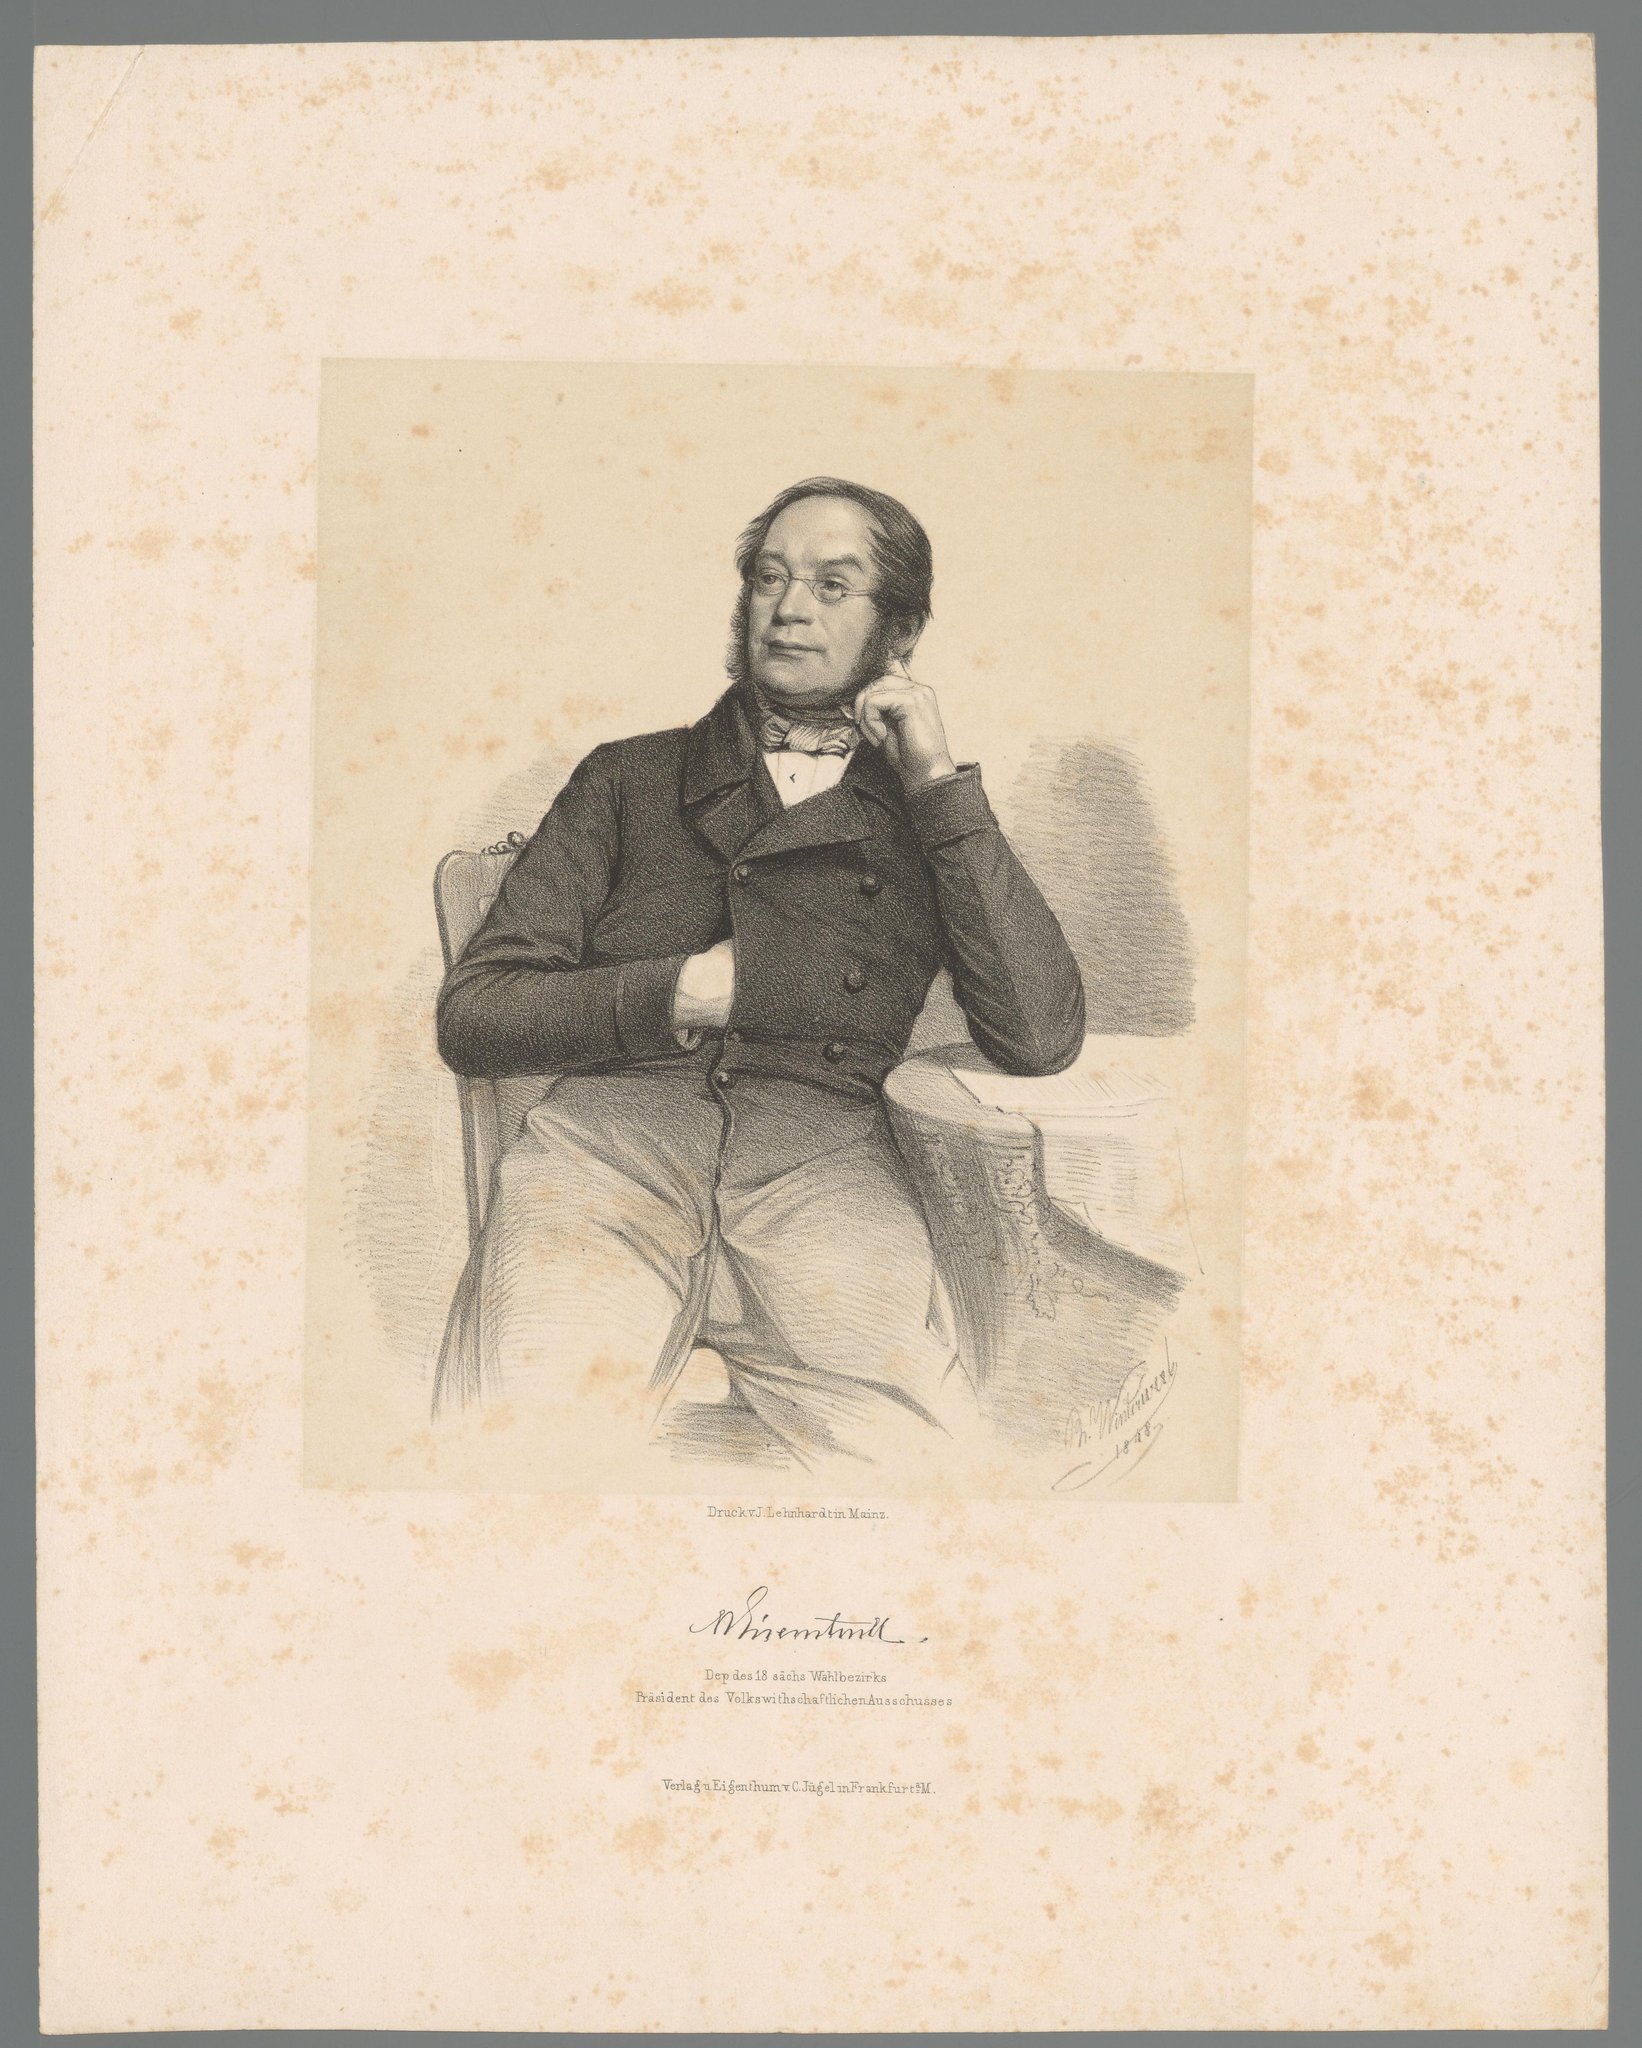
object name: print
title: Portret van Bernhard Eisenstuck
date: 1849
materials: paper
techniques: tone lithography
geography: mainz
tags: politician, manufacturer, eyeglasses, spectacles, sitting figure, adult man, historical persons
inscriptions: collector's mark: Lugt 2228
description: Prent behoort waarschijnlijk tot de serie 'Album der deutschen National-Versammlung'. Deze serie bestaat uit circa 54 portretten die onder andere zijn vervaardigd door Philipp Winterwerb en Heinrich Hasselhorst naar foto's van Seib. Deze serie is in 1849 uitgegeven door Carl Christian Jügel.